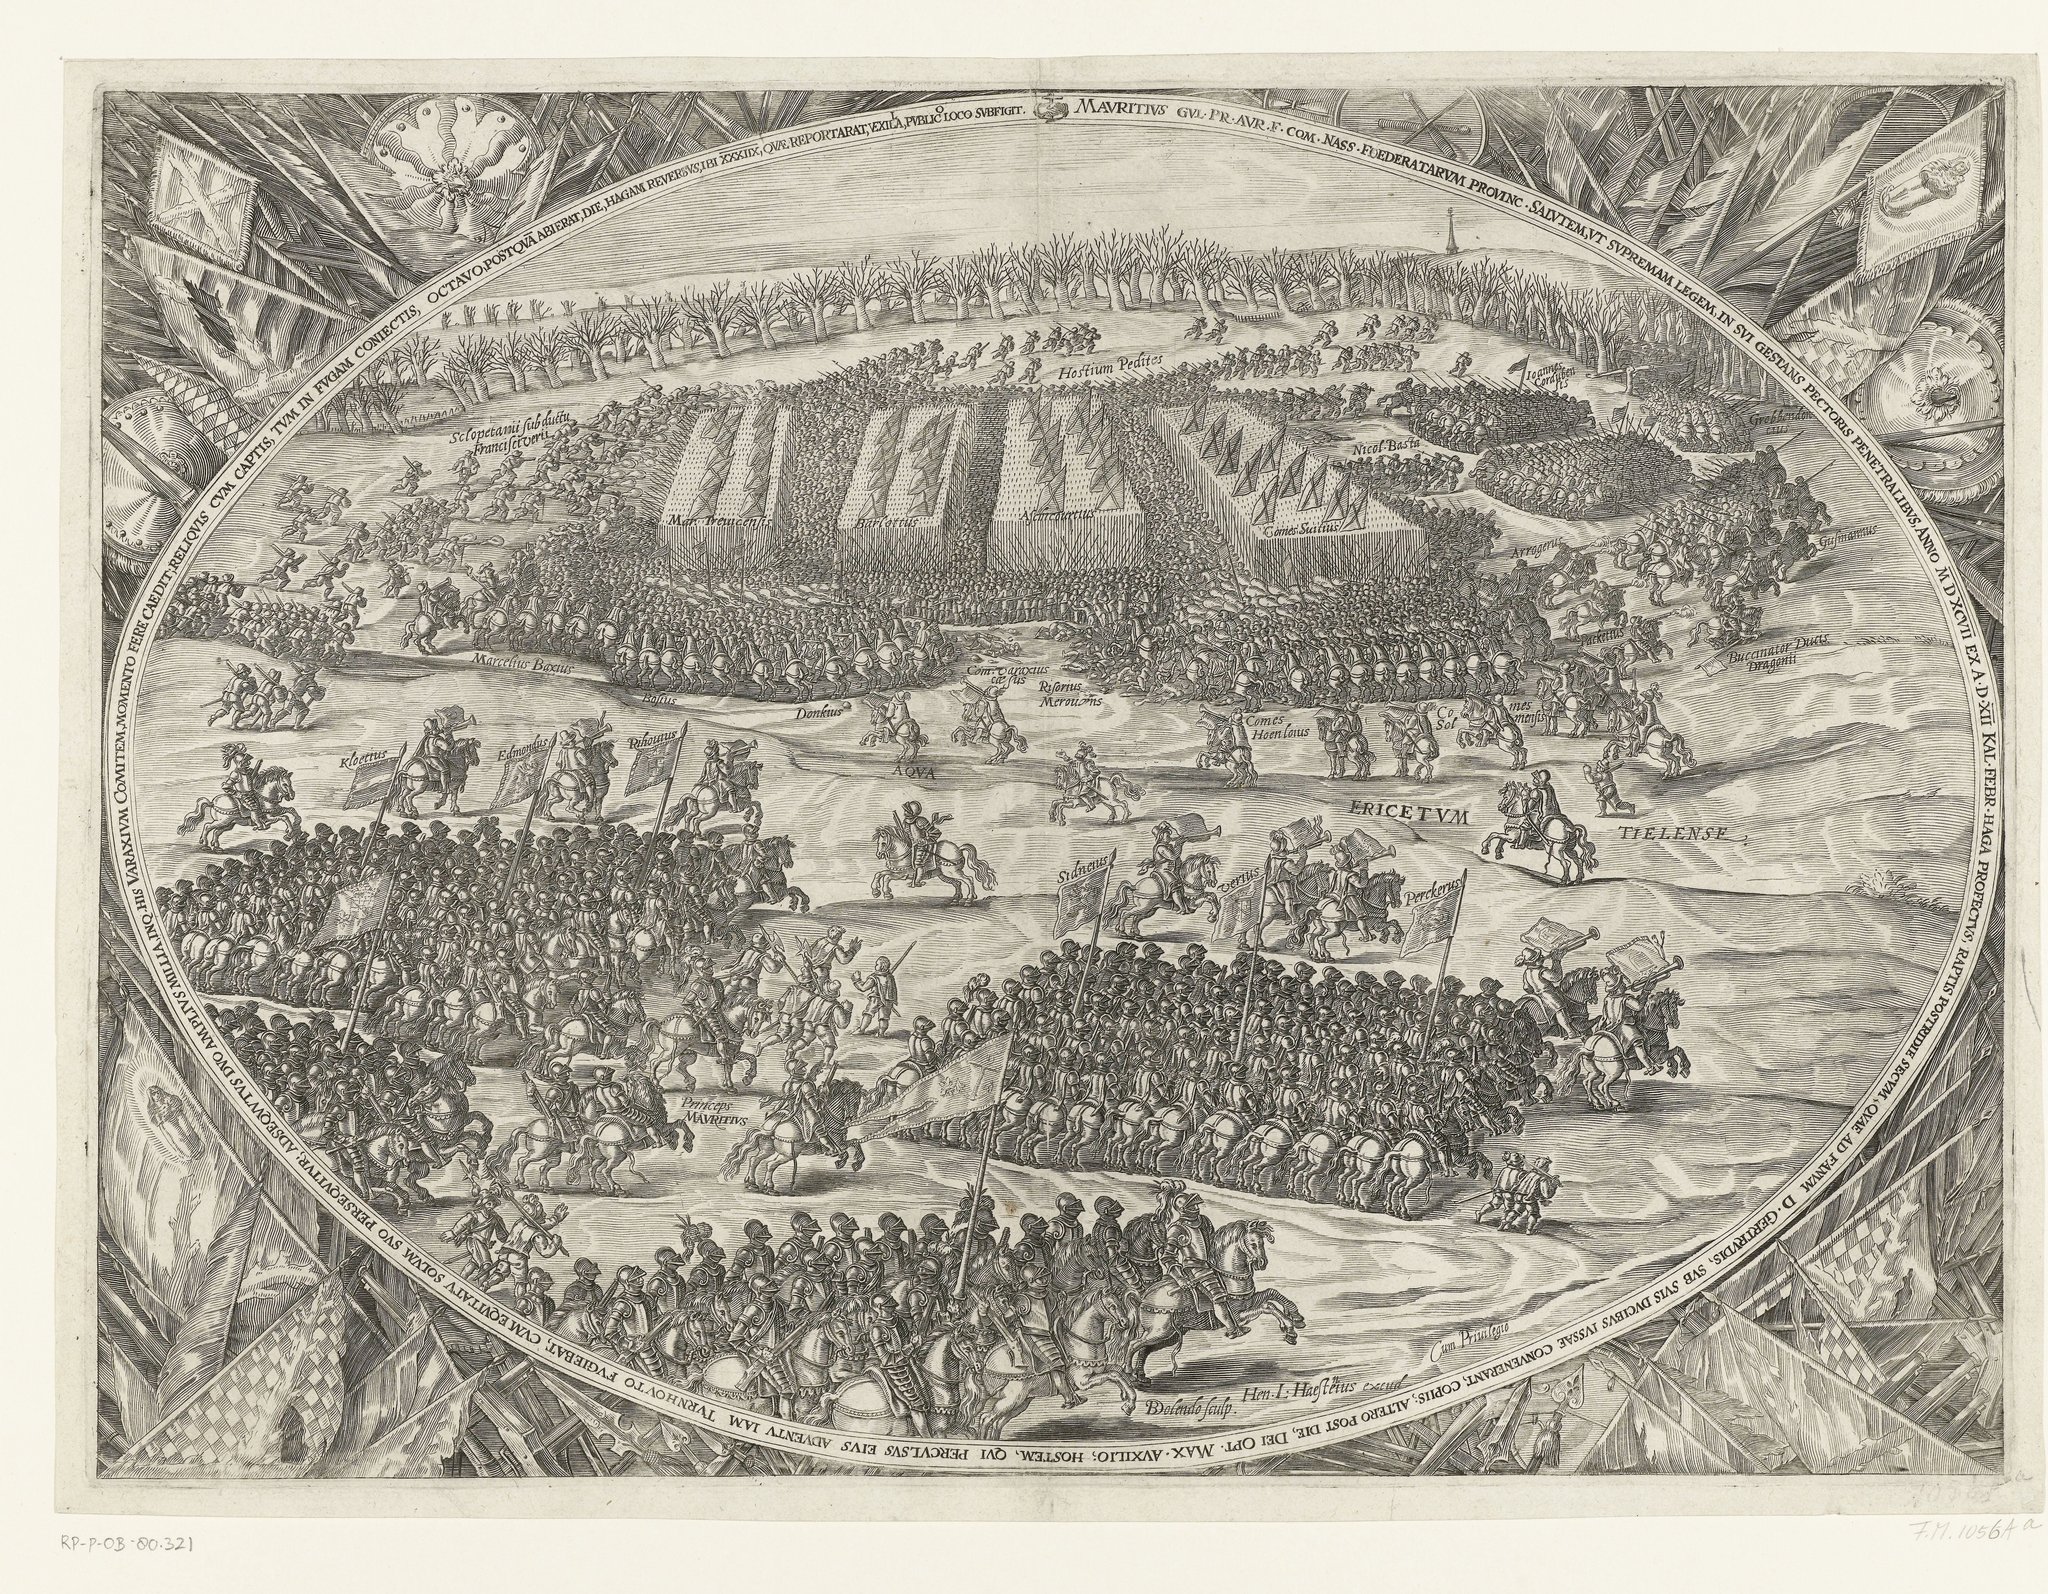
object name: print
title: Slag bij Turnhout, 1597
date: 1600-1601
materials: paper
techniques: engraving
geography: northern netherlands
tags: battle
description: Grote ovale voorstelling van de slag bij Turnhout, 24 januari 1597. Links het oprukkende leger onder Maurits, rechts de Engelse ruiters onder Robert Sidney en Francis Vere. Boven de veldslag en de vluchtende Spaanse troepen. Om de voorstelling een randschrift in het Latijn, in de hoeken trofeeën van buitgemaakte wapens en vaandels.